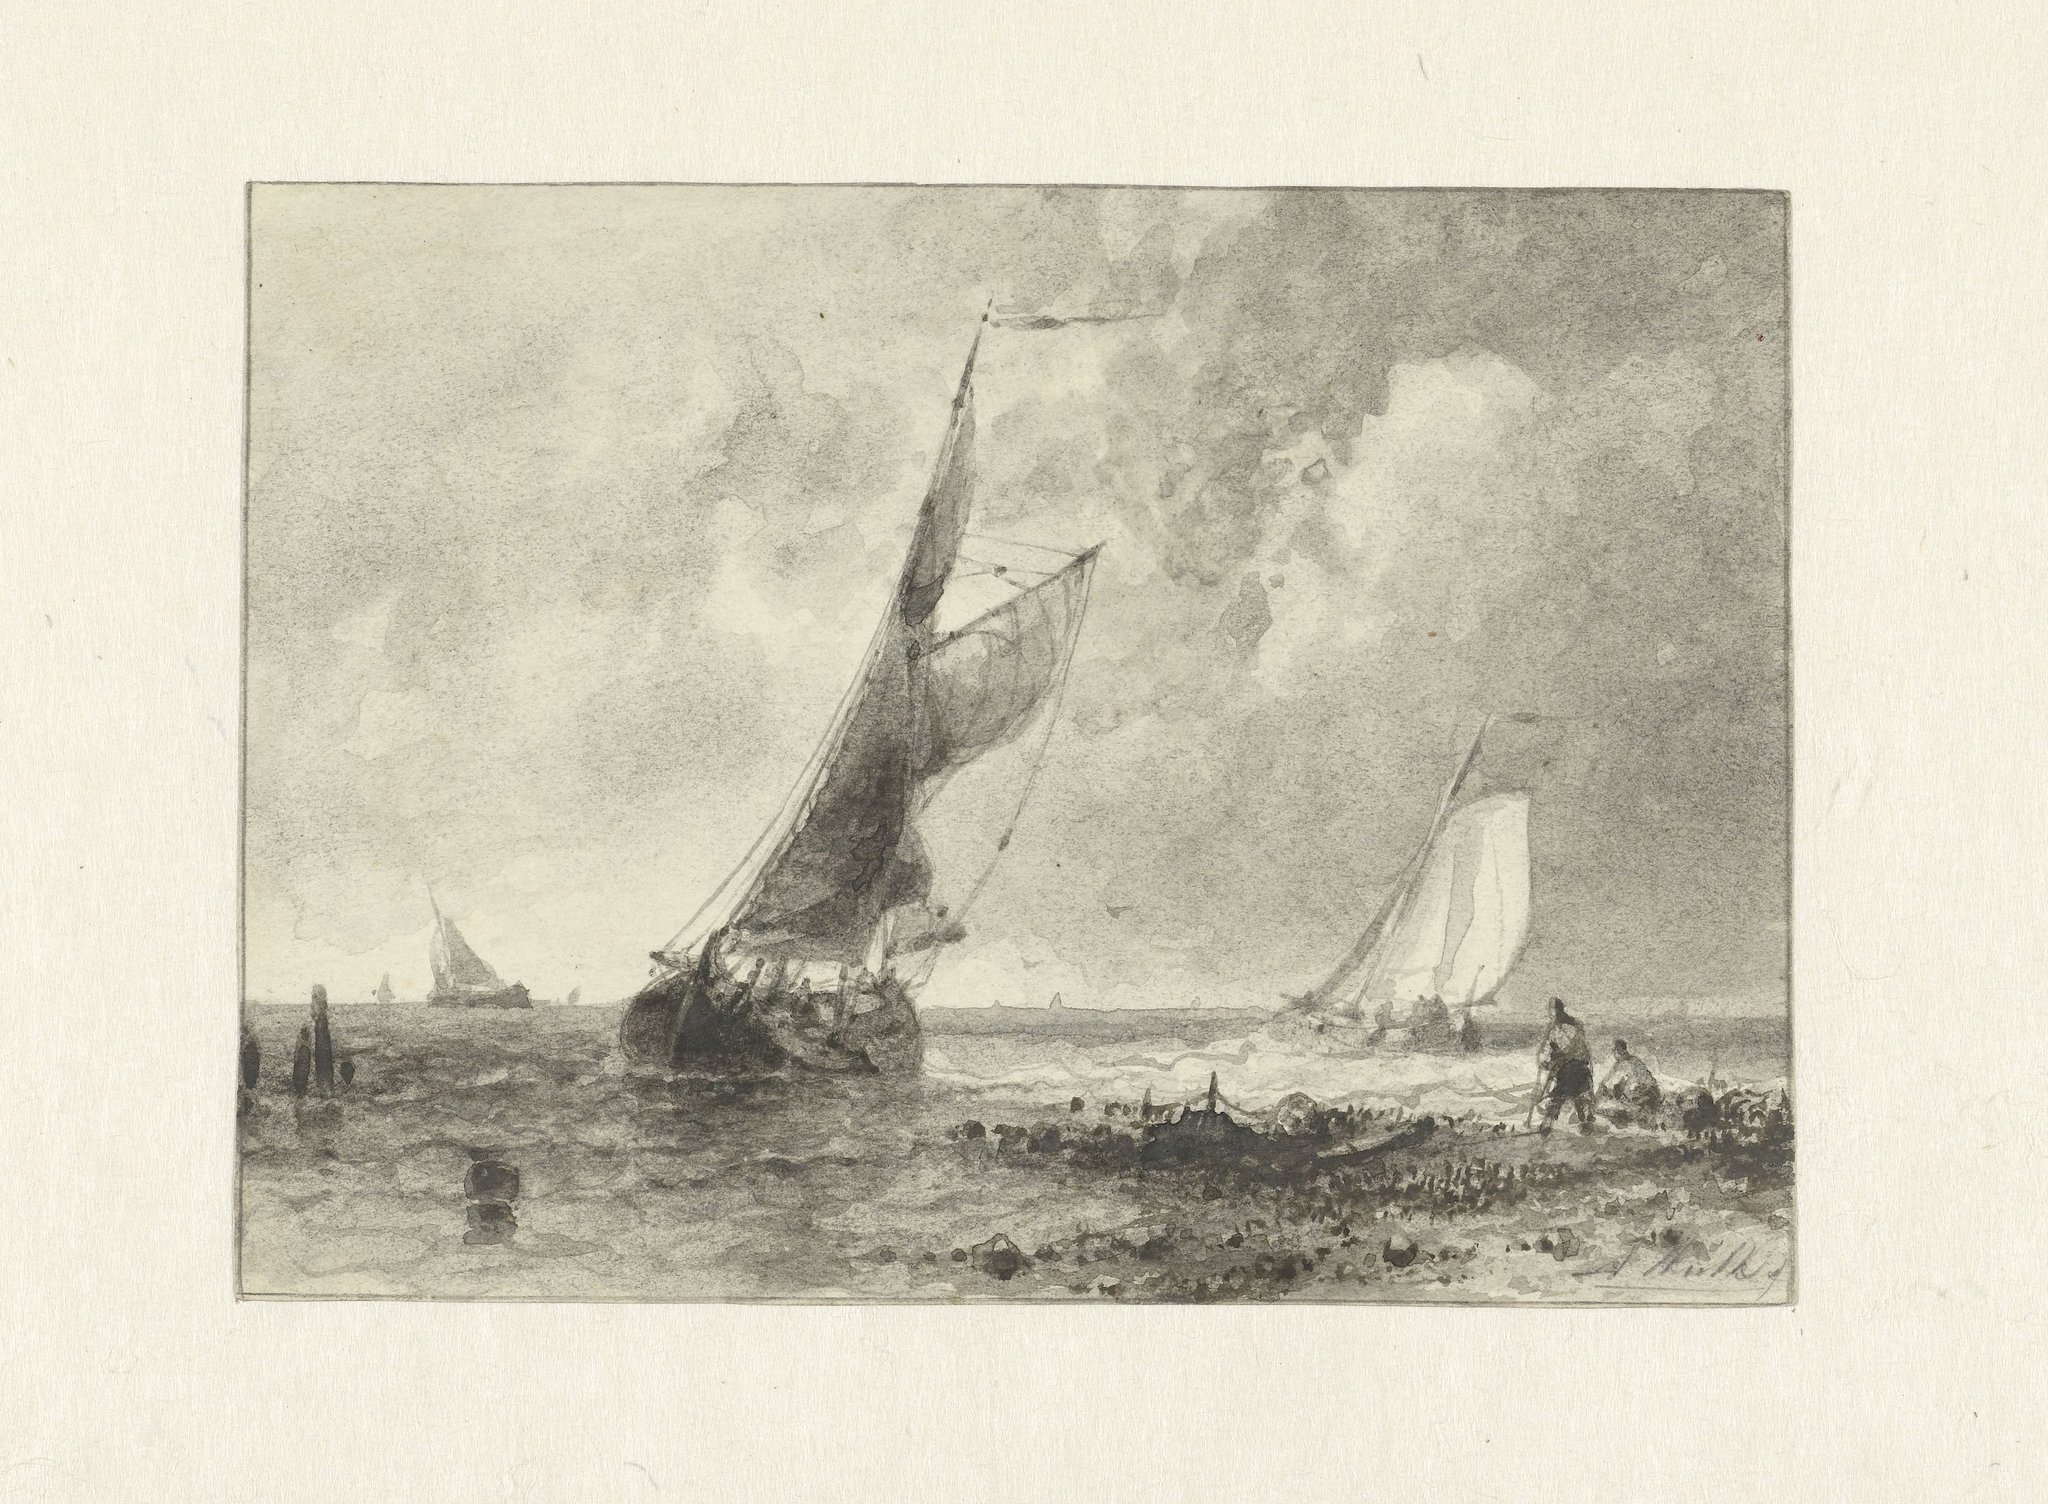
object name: drawing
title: Enkele zeilschepen voor de kust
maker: abraham hulk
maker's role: draughtsman, painter, print maker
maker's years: 1813-1897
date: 1823-1897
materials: chalk, paper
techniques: brush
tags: sailing-ship, sailing-boat, coast